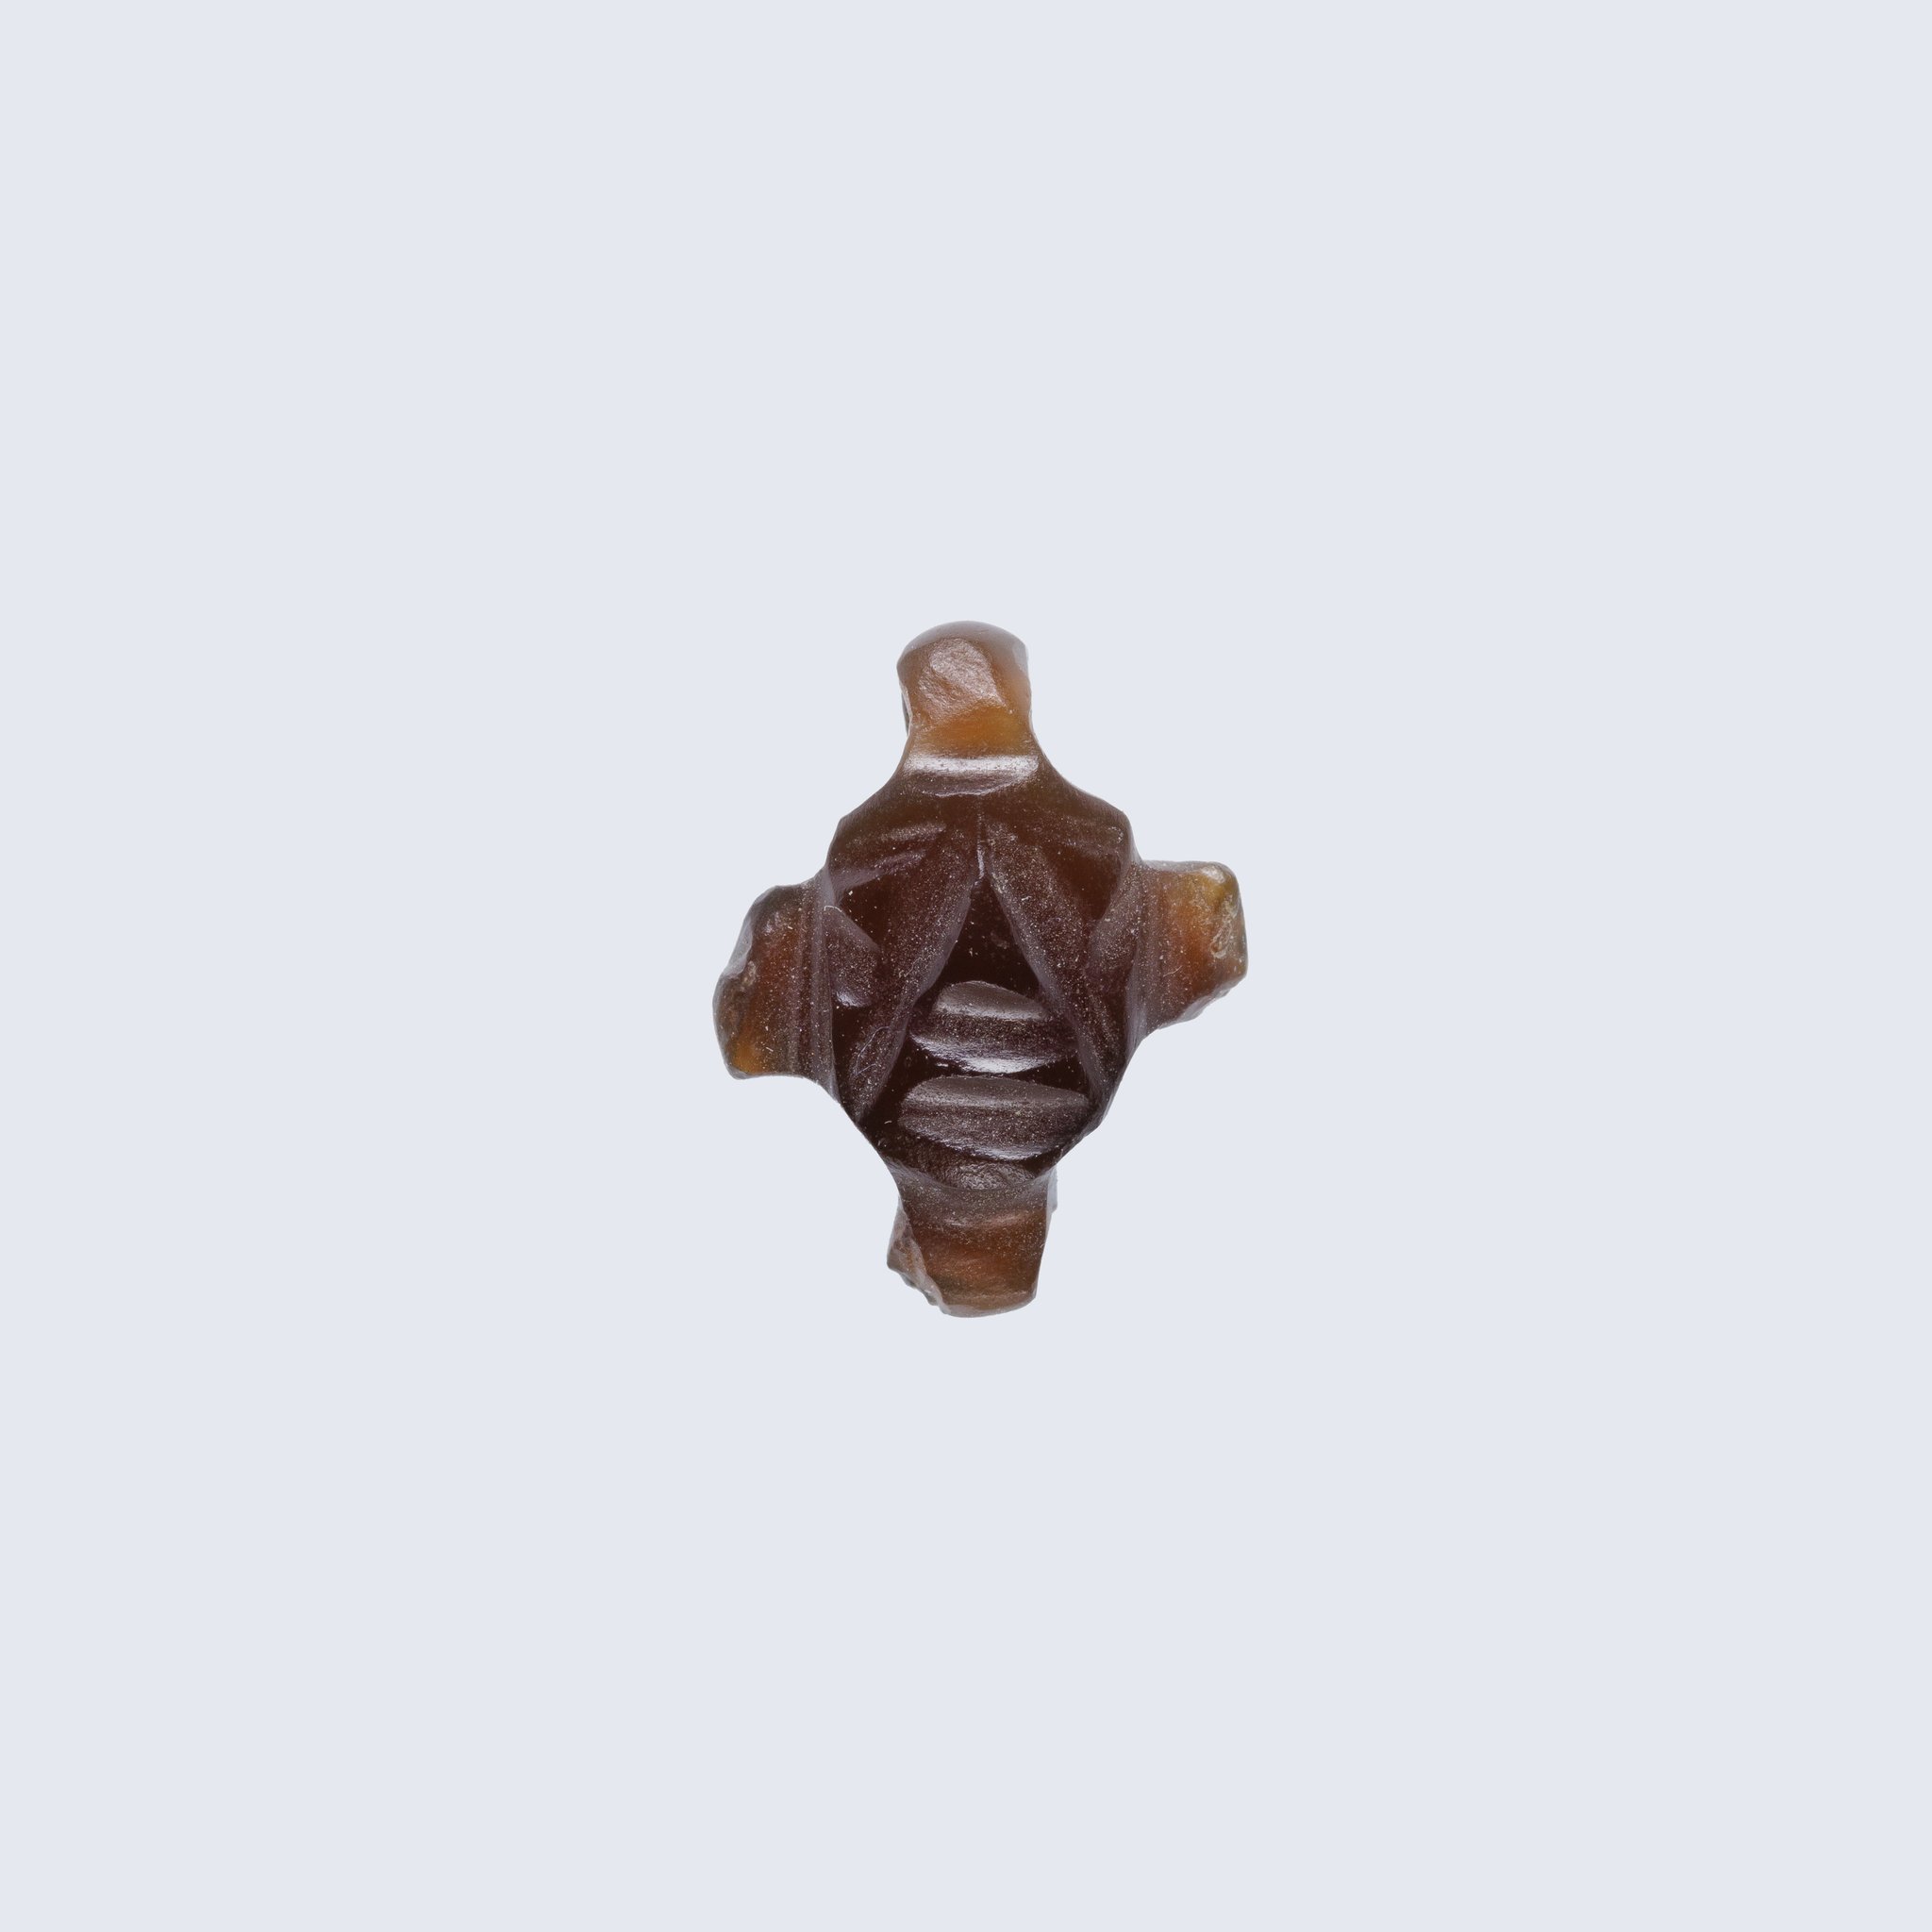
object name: amulet, face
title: Face Amulet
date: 2150-1950 BCE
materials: gemstone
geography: southern upper egypt